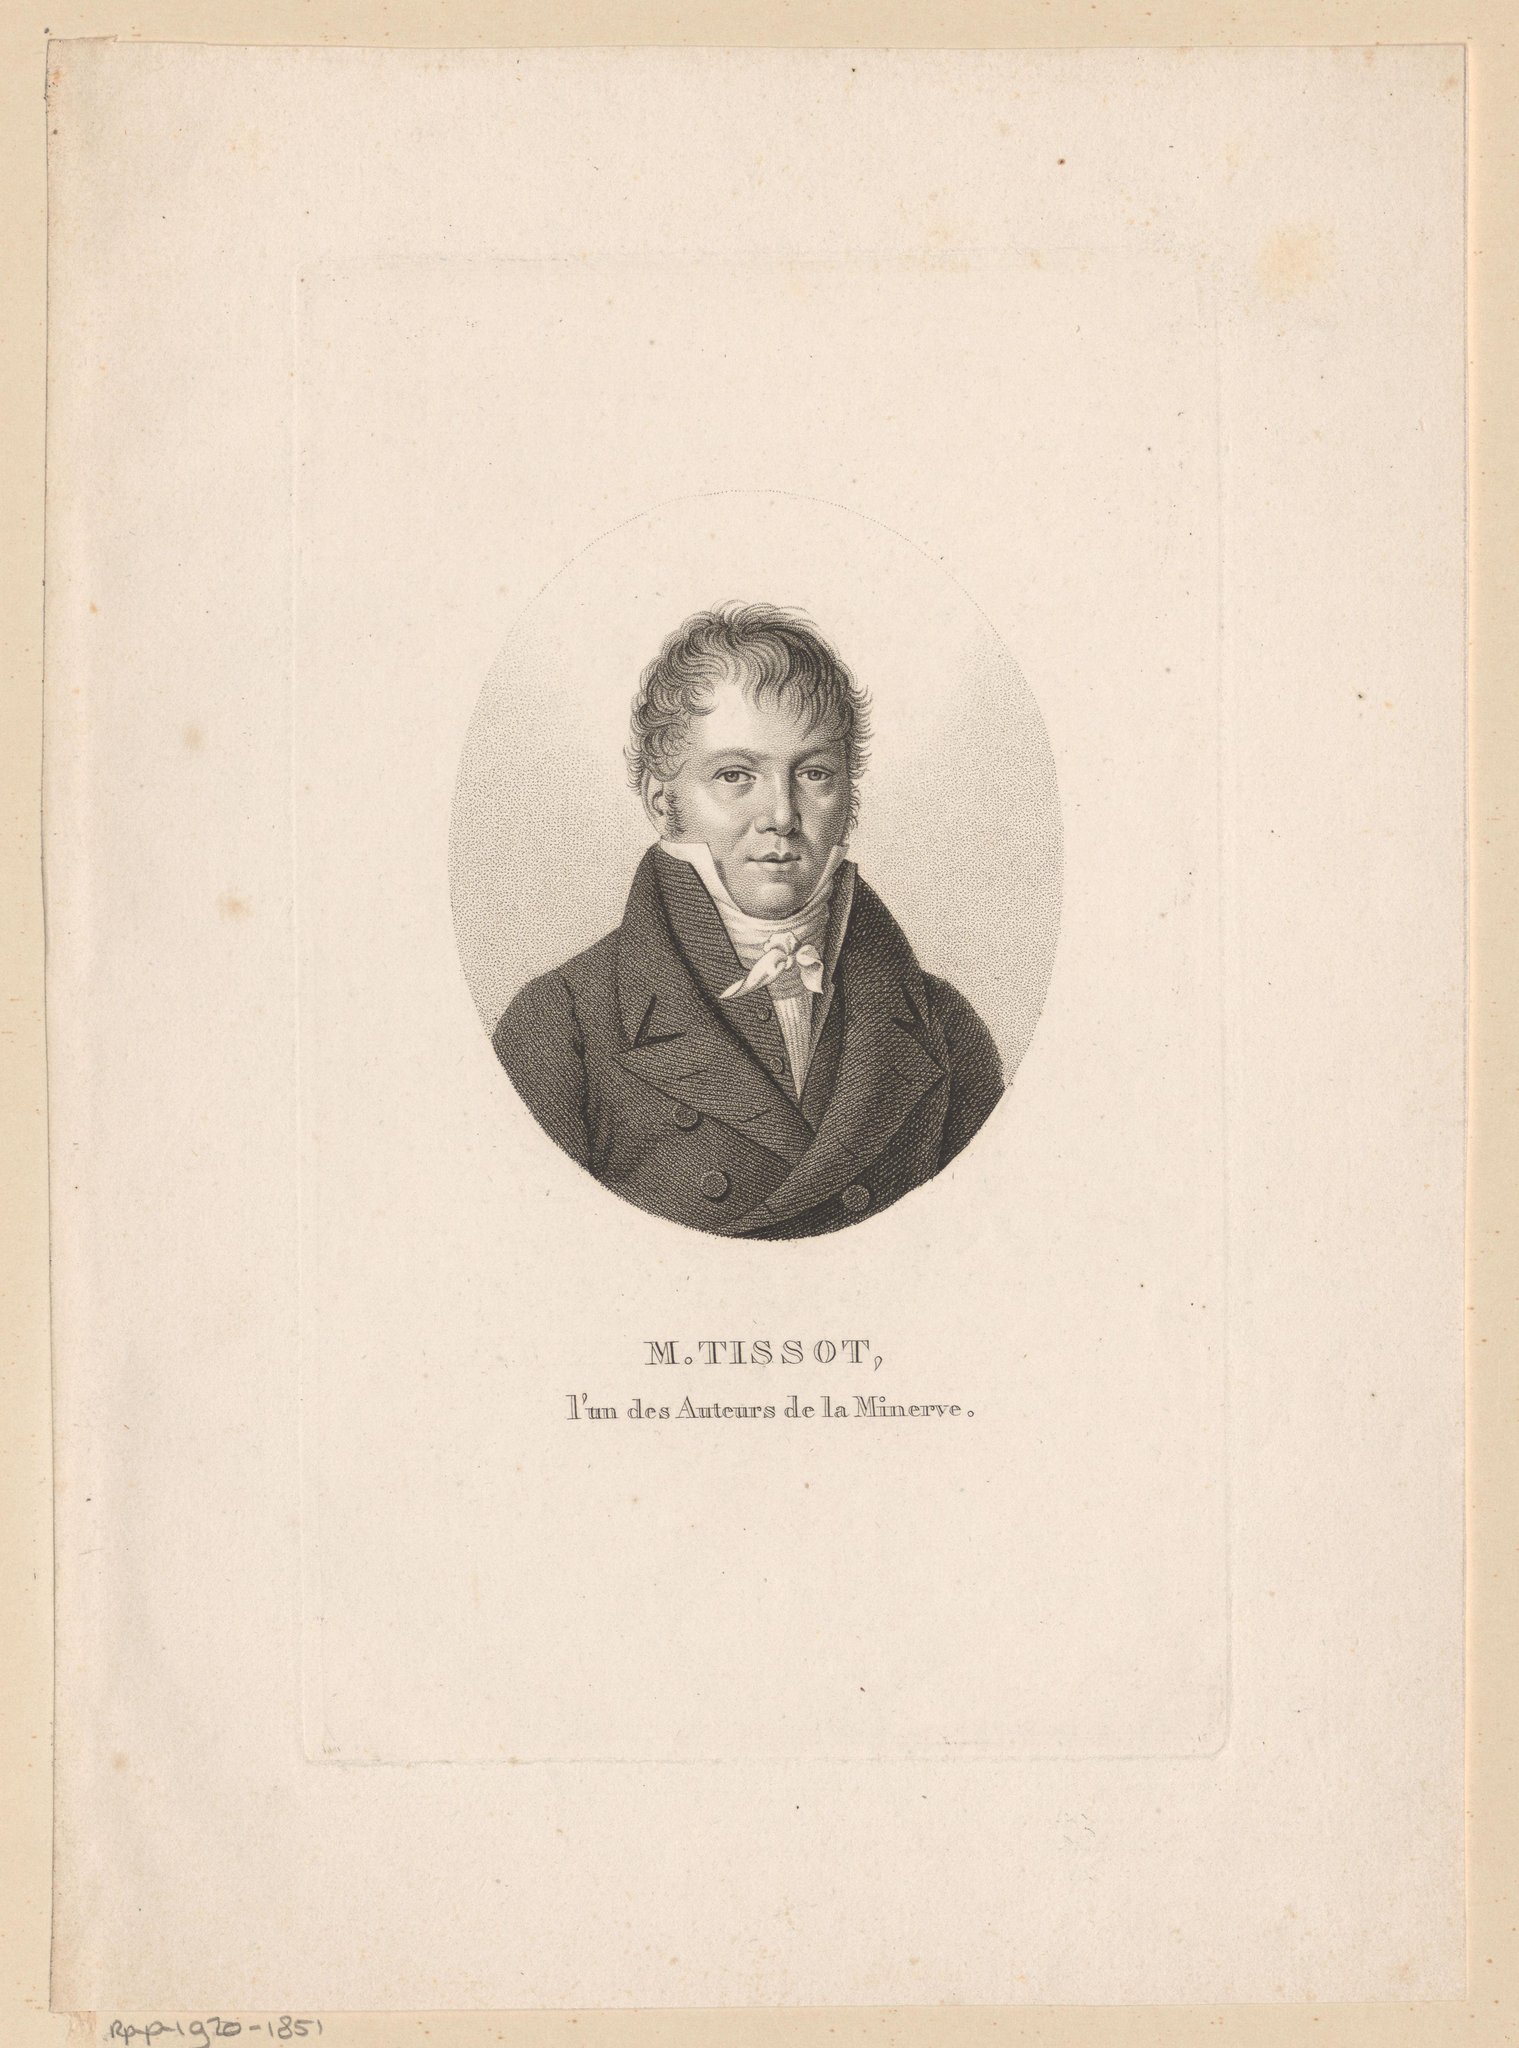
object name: print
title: Portret van Pierre François Tissot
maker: Anonymous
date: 1793-1849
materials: paper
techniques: etching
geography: france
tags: historical persons, portrait of a writer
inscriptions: collector's mark: Lugt 2228